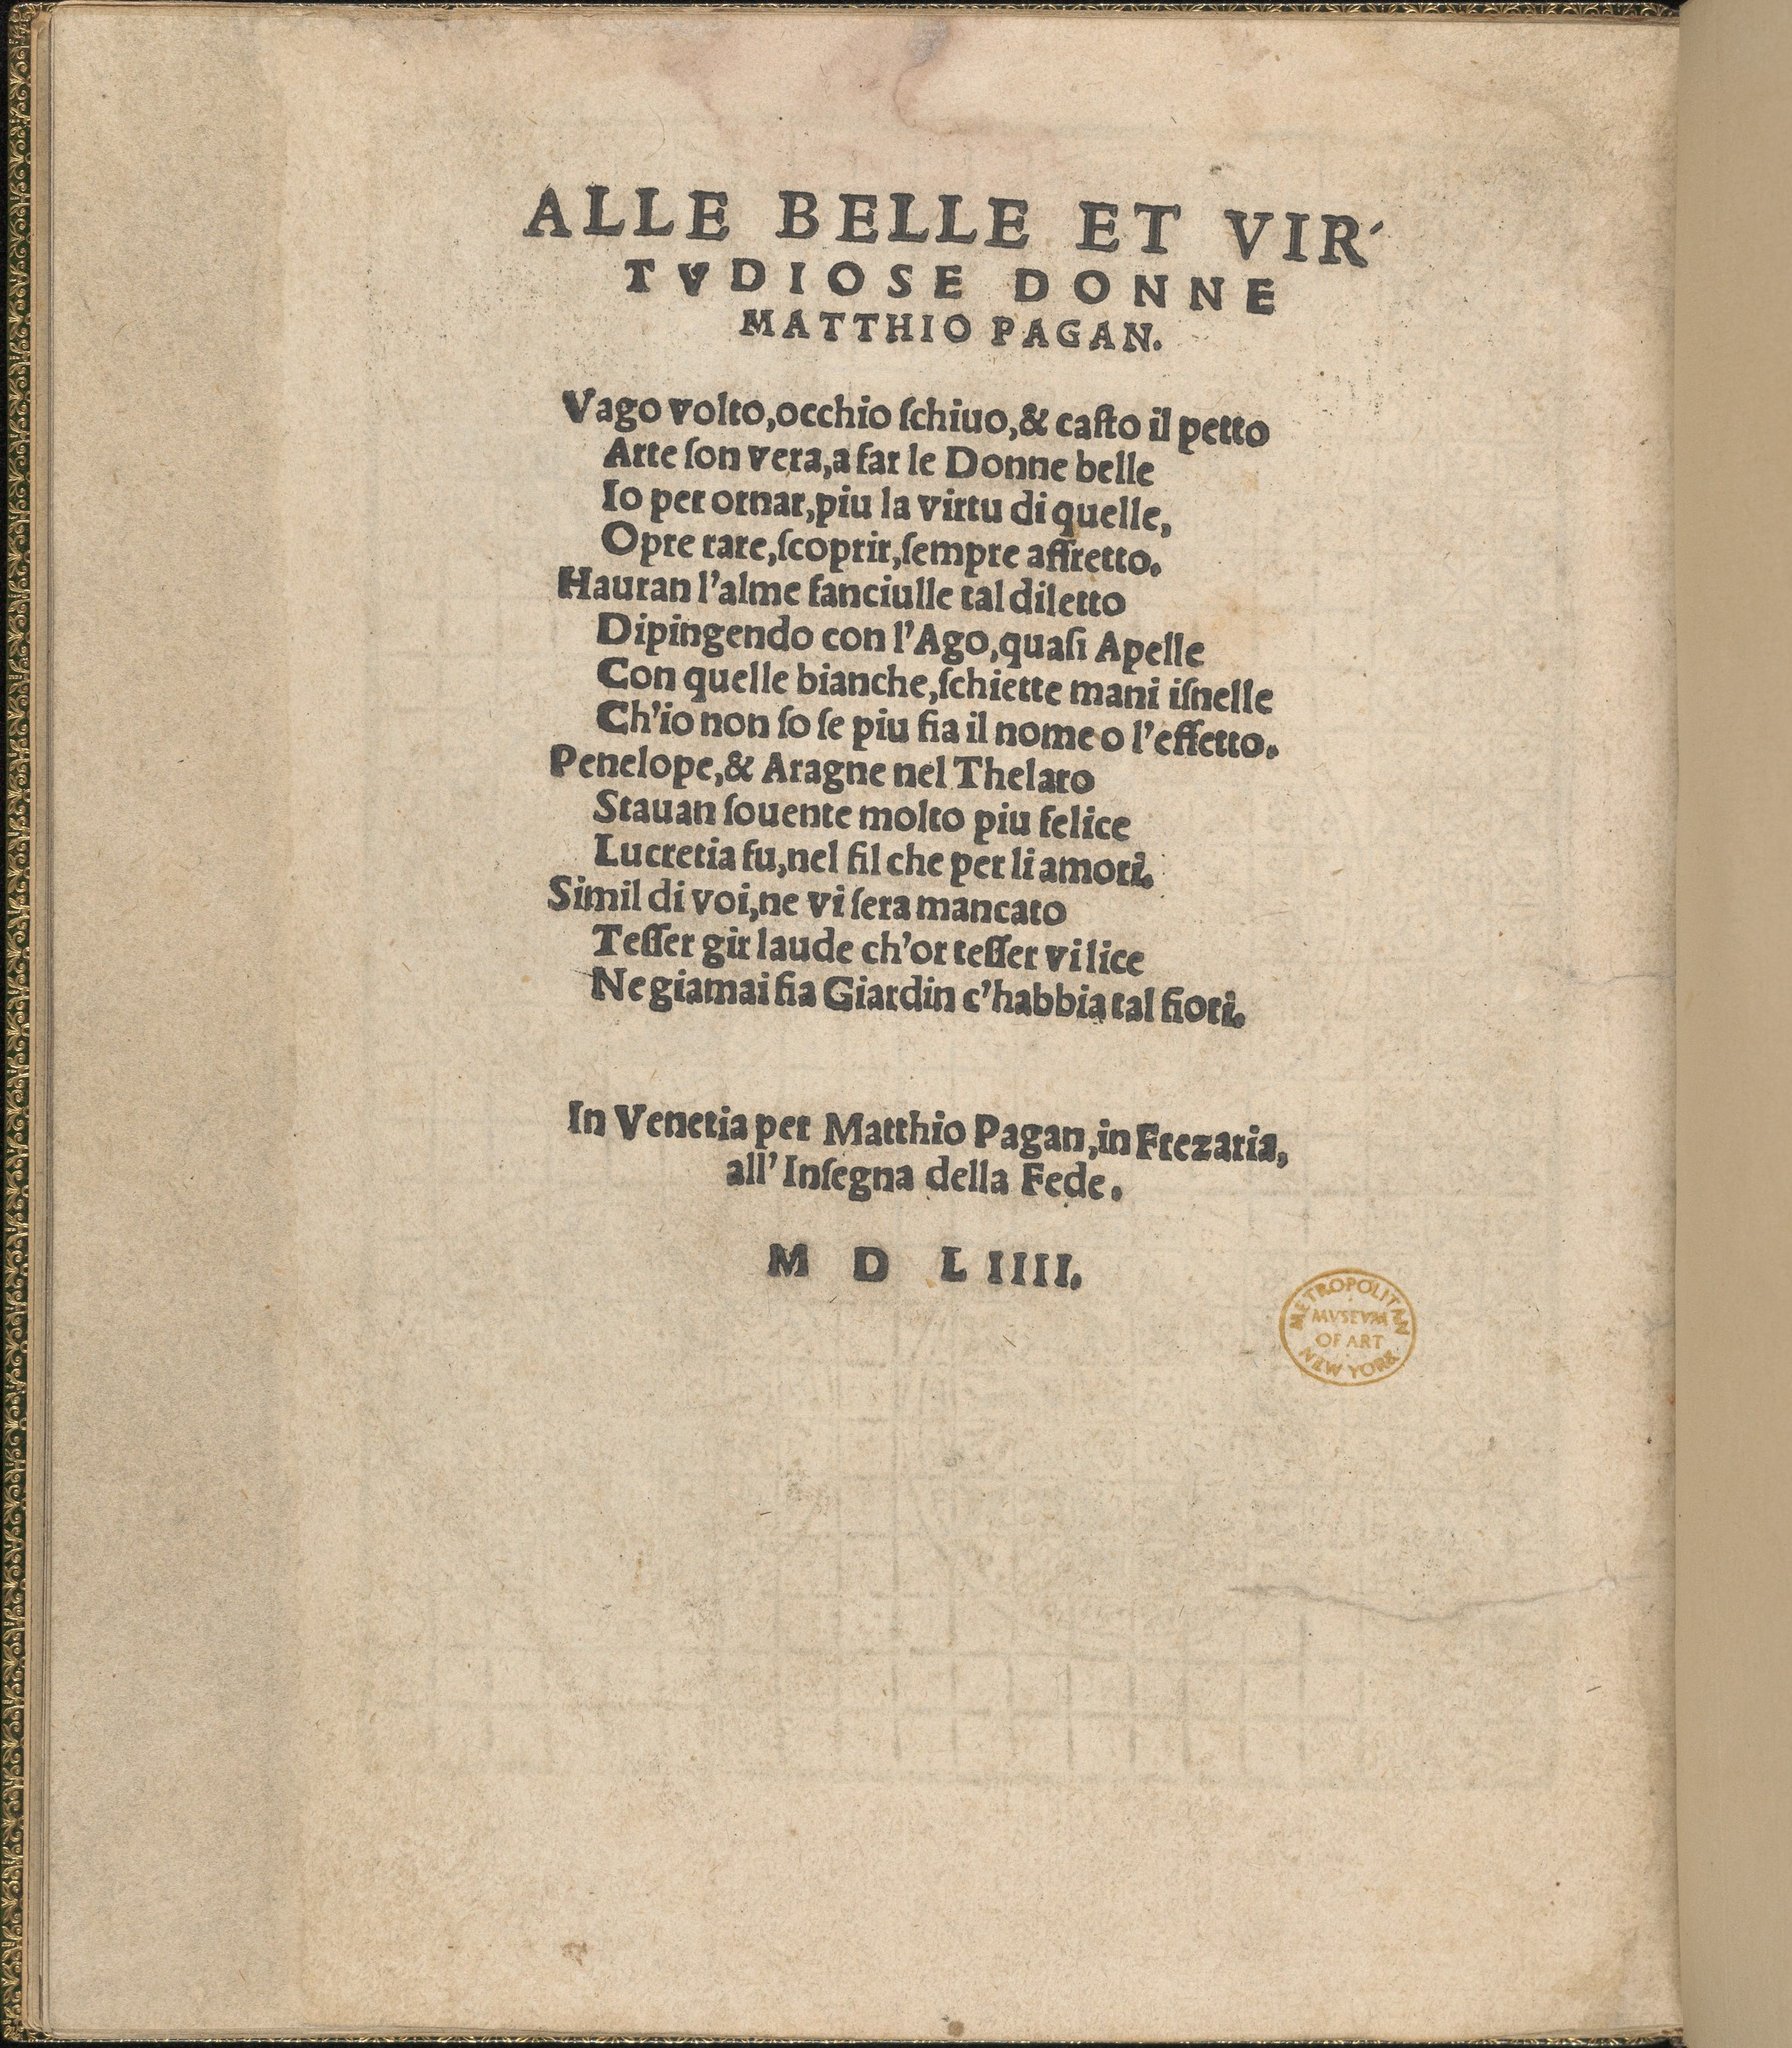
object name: book print ornament architecture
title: Giardineto novo di punti tagliati et gropposi per exercitio & ornamento delle donne (Venice 1554), page 13 (verso)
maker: matteo pagano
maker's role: publisher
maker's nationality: italian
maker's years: 1515-1588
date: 1554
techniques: woodcut